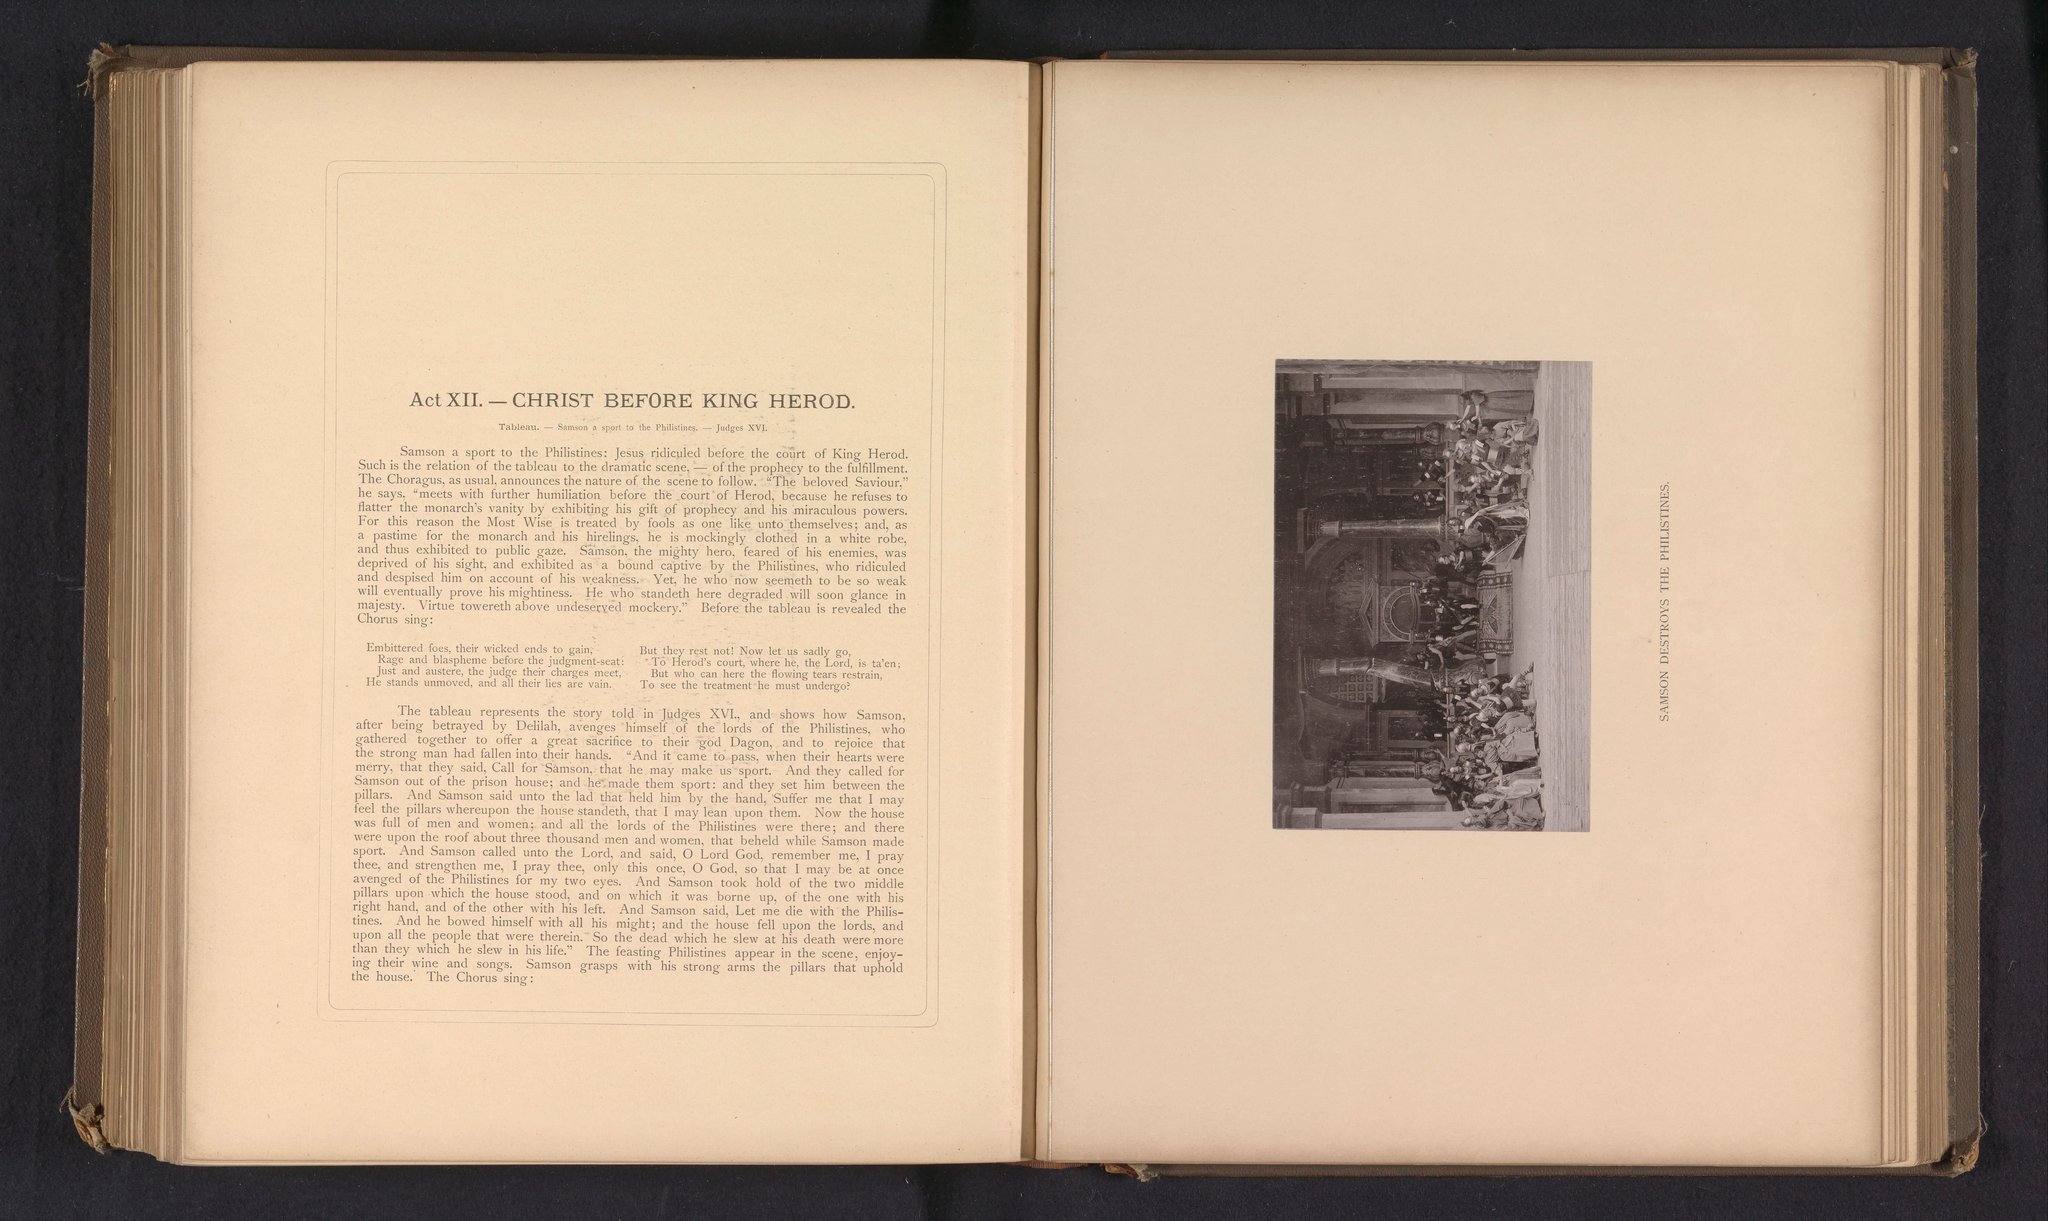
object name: page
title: Samson destroys the Philistines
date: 1885-1890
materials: paper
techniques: photograph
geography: oberammergau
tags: samson breaks the pillars; the temple of dagon collapses, killing all that are in it, group of actors, troupe; actors on the stage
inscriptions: inscription: ‘Gemeinde Oberammergau Passionsspiel 1890’